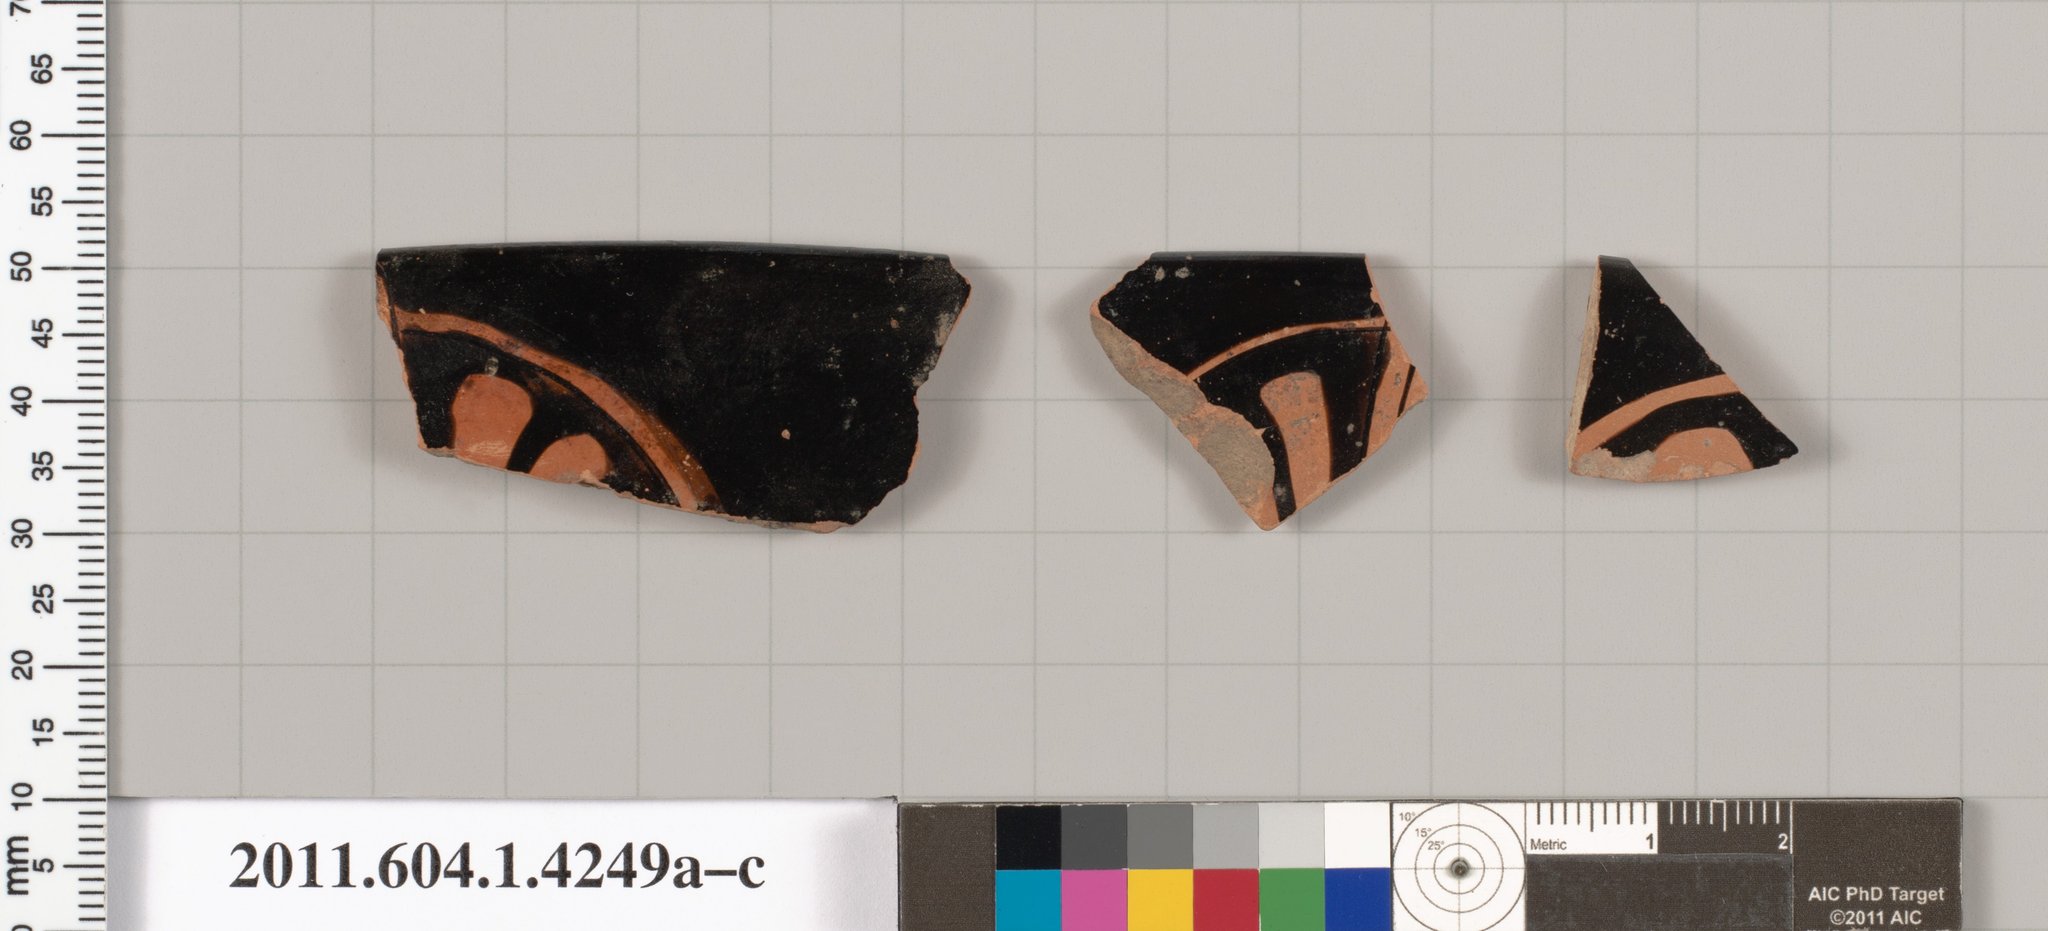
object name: kylix fragment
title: Terracotta rim fragments of kylikes (drinking cups)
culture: greek, attic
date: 500-451 BCE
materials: terracotta